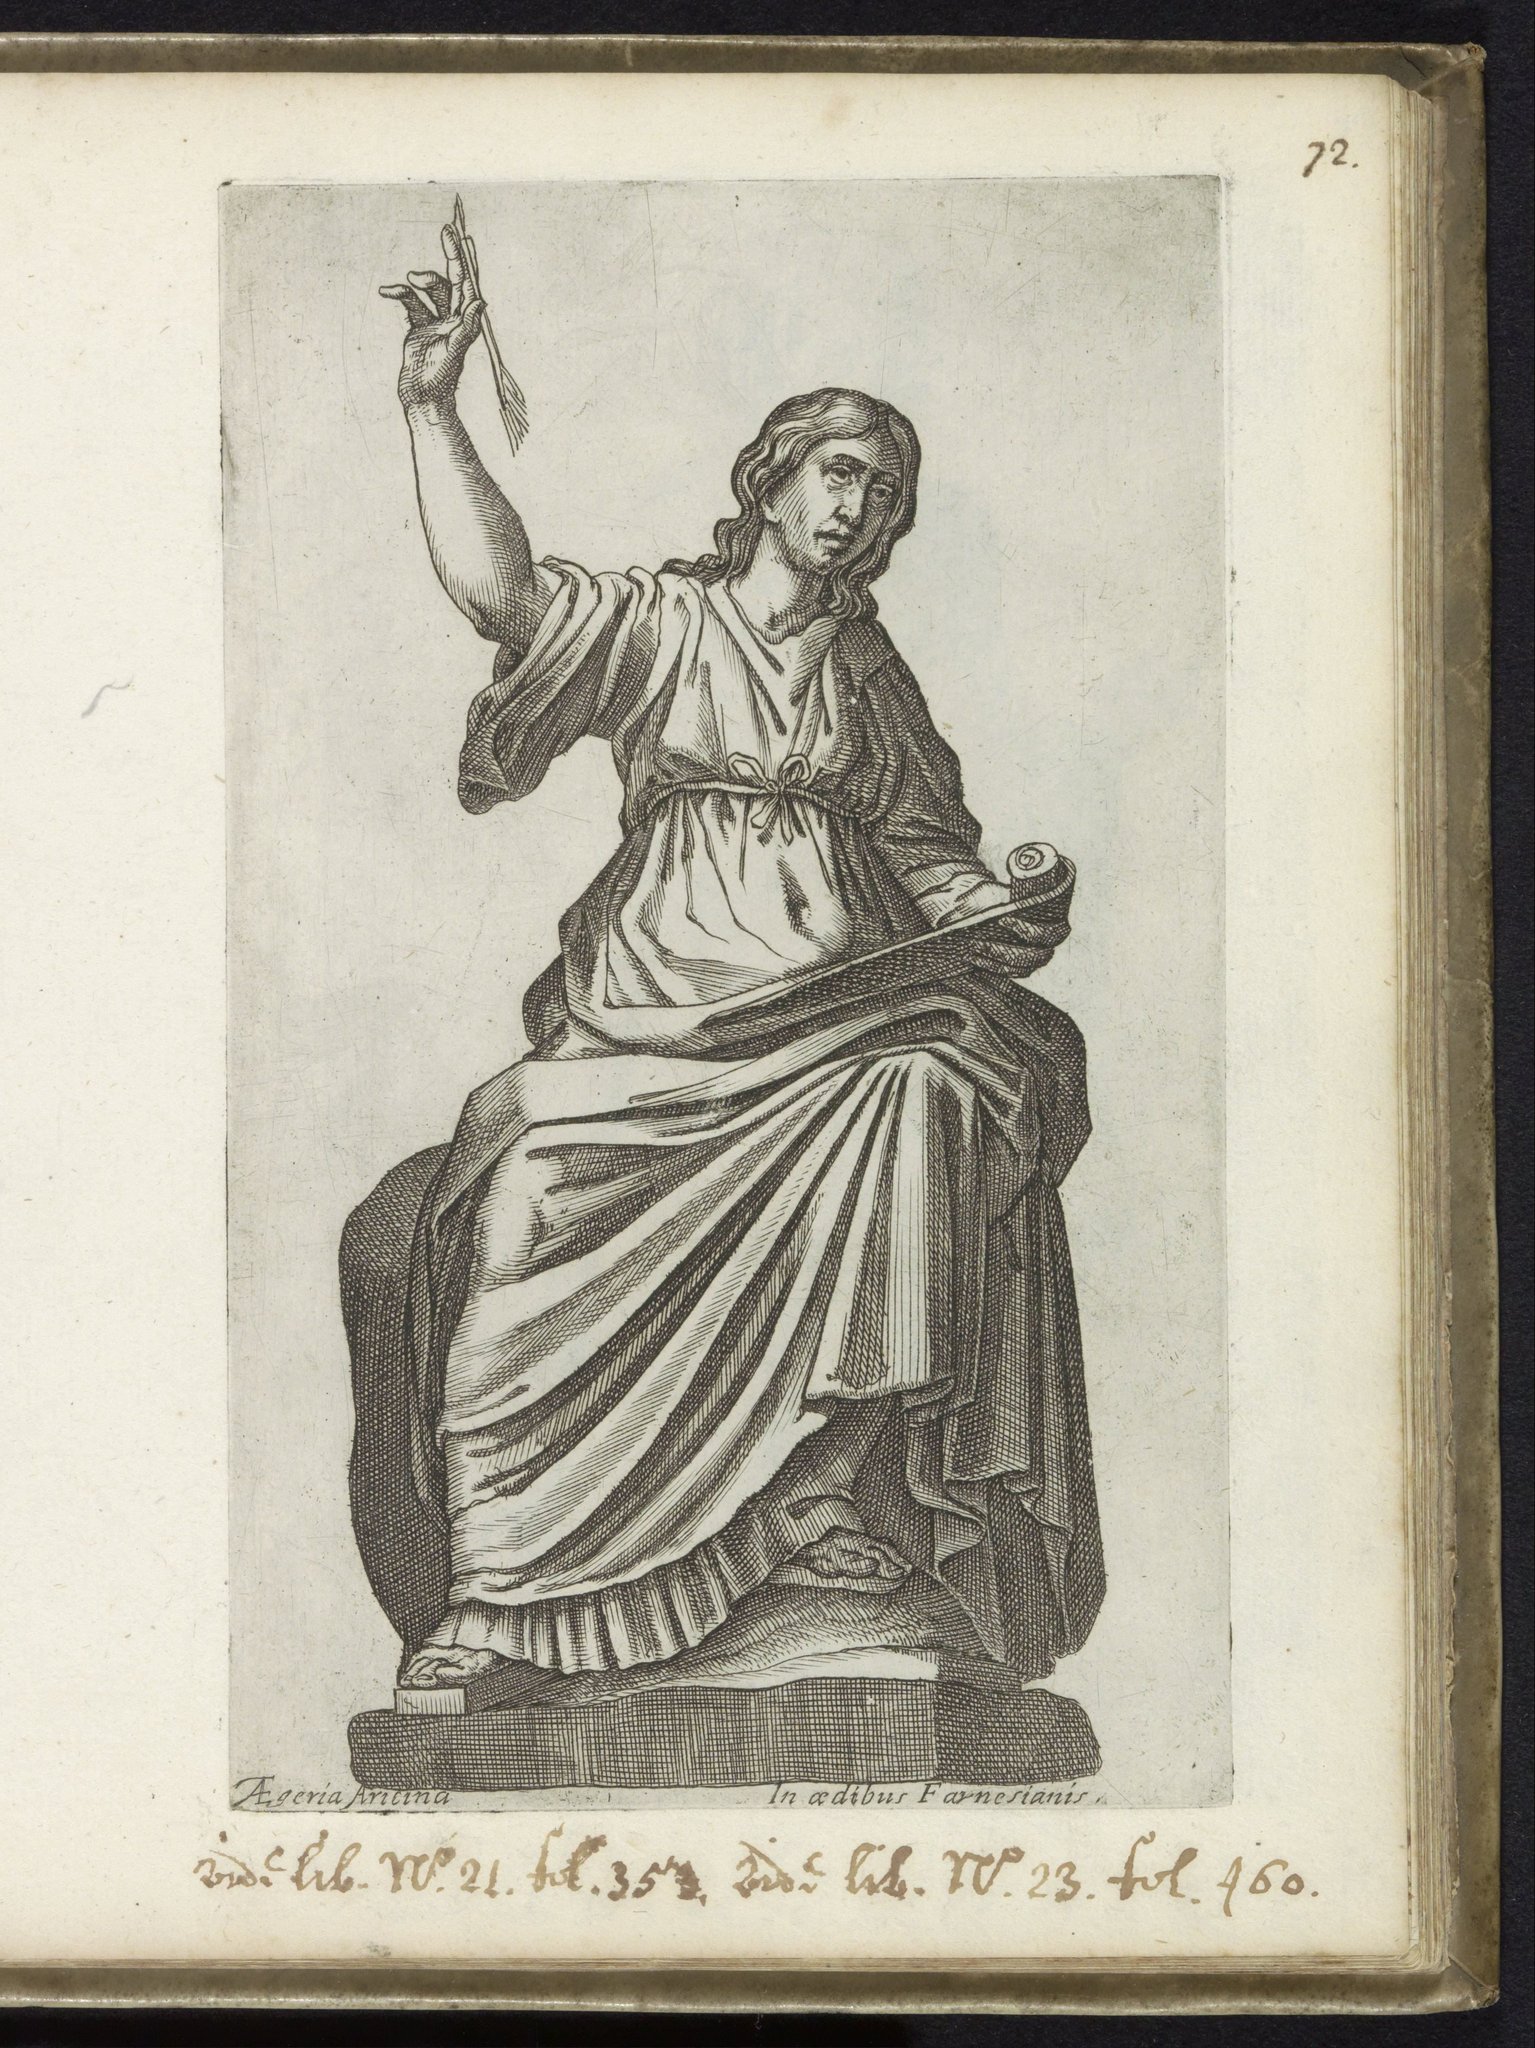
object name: album leaf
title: Sculptuur van de nimf Aegeria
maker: Anonymous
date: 1600-1699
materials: paper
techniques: engraving, etching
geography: italy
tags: egeria (roman fountain-deity), piece of sculpture, reproduction of a piece of sculpture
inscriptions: number: ‘72’, inscription: ‘Ende lib. No. 21. fol. 35. Ende lib. No. 23. fol. 460.’, inscription: ‘Ende lib. No. 21. fol. 339/ Ende lib. No. 1. fol. 48. Ende lib. No. 23. fol. 79.’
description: Deze prent maakt deel uit van een reeks van ten minste 50 prenten van sculpturen uit de oudheid.